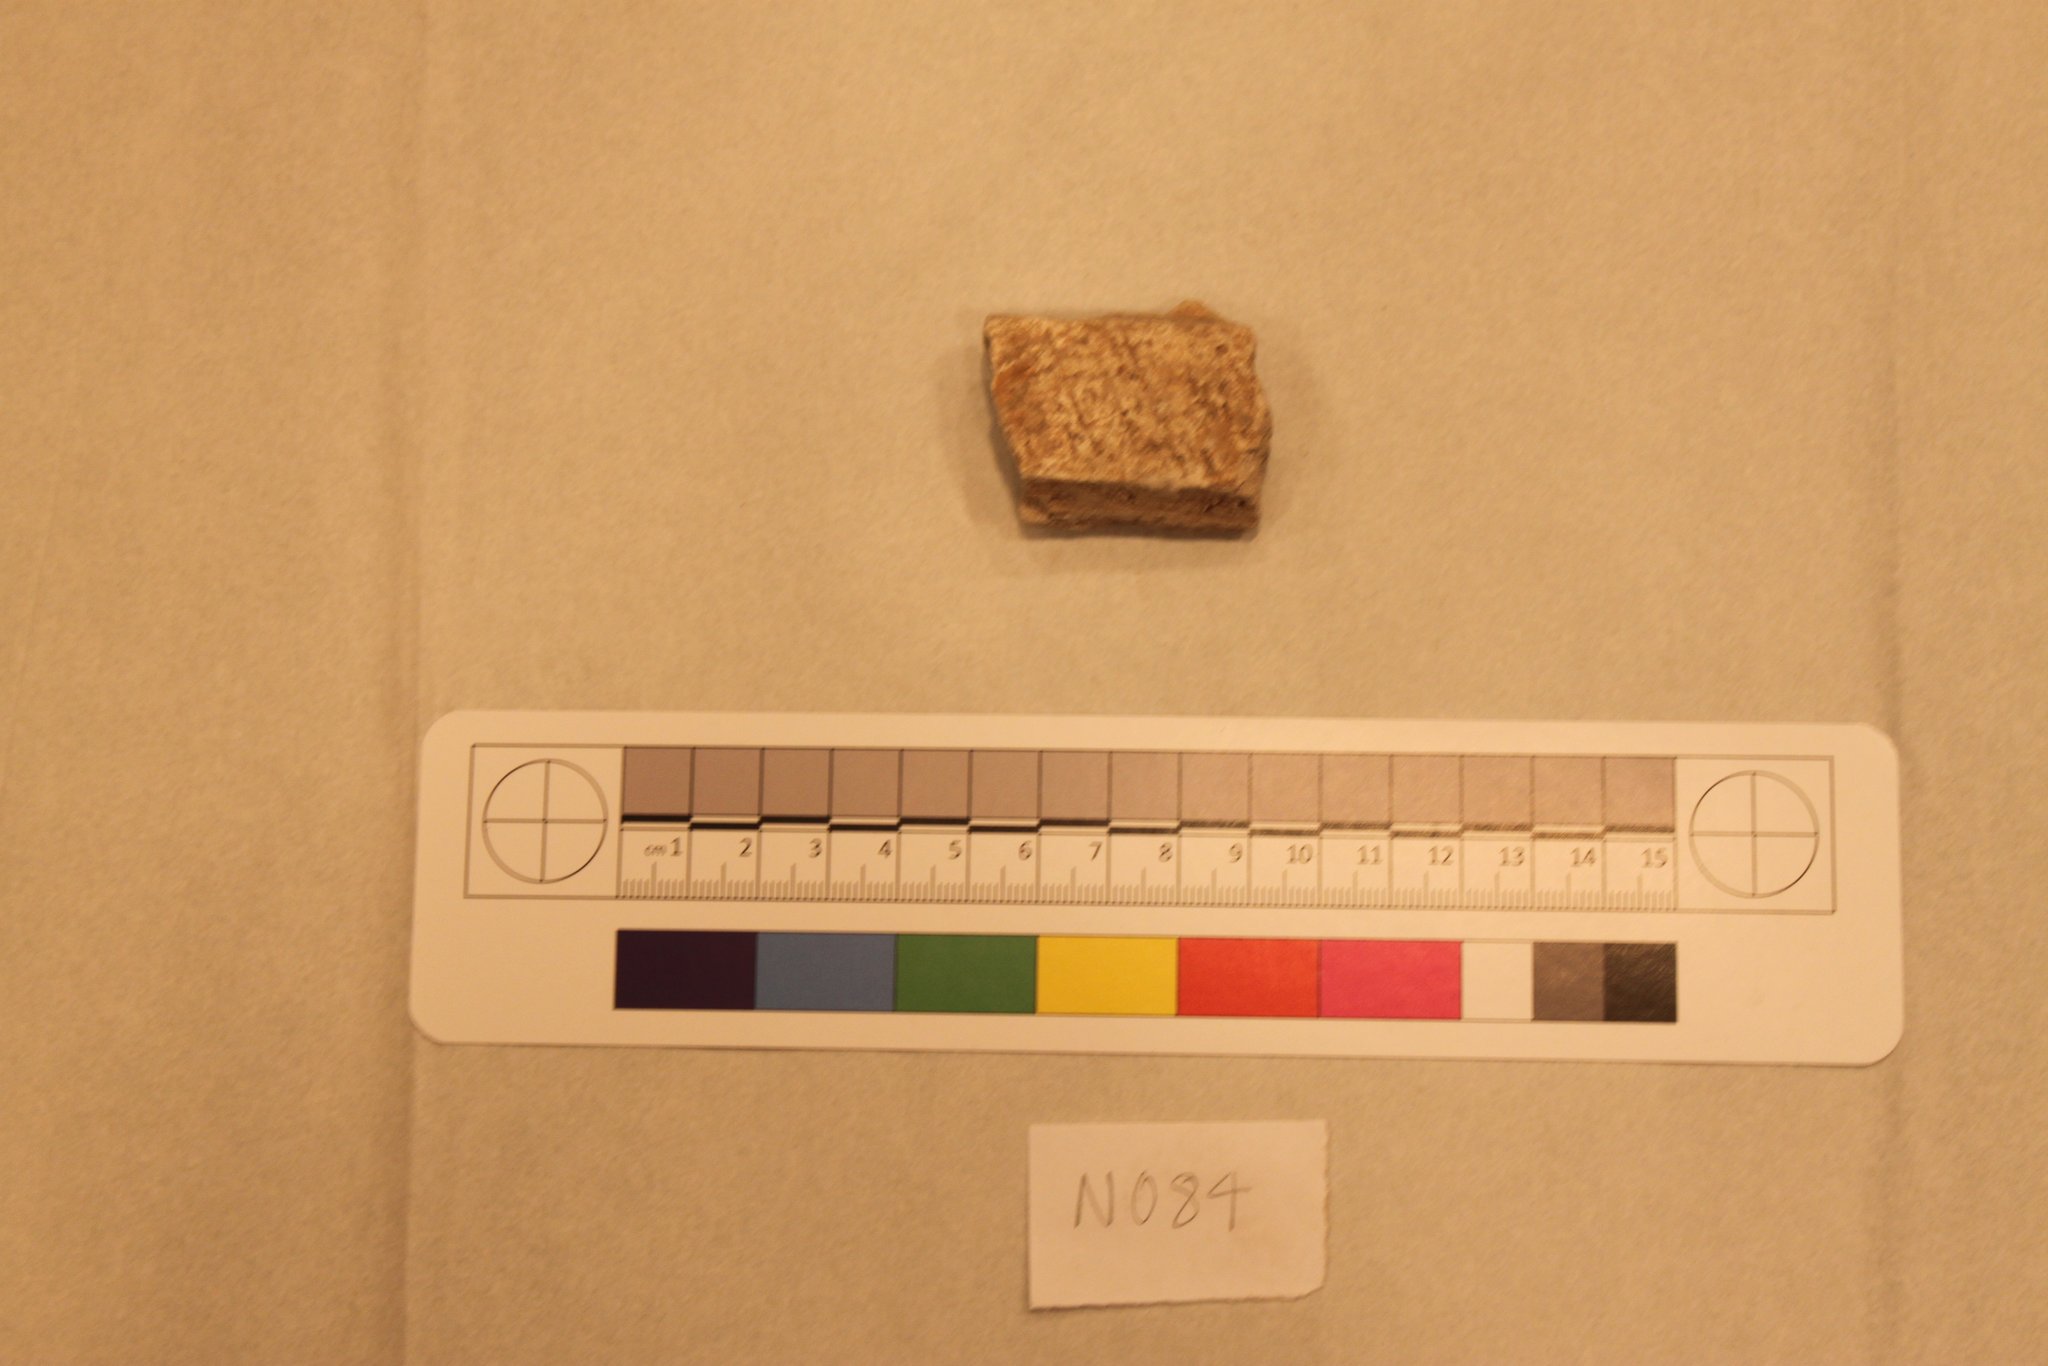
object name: fragment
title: Stucco Fragment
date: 701-1200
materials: plaster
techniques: painting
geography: iran